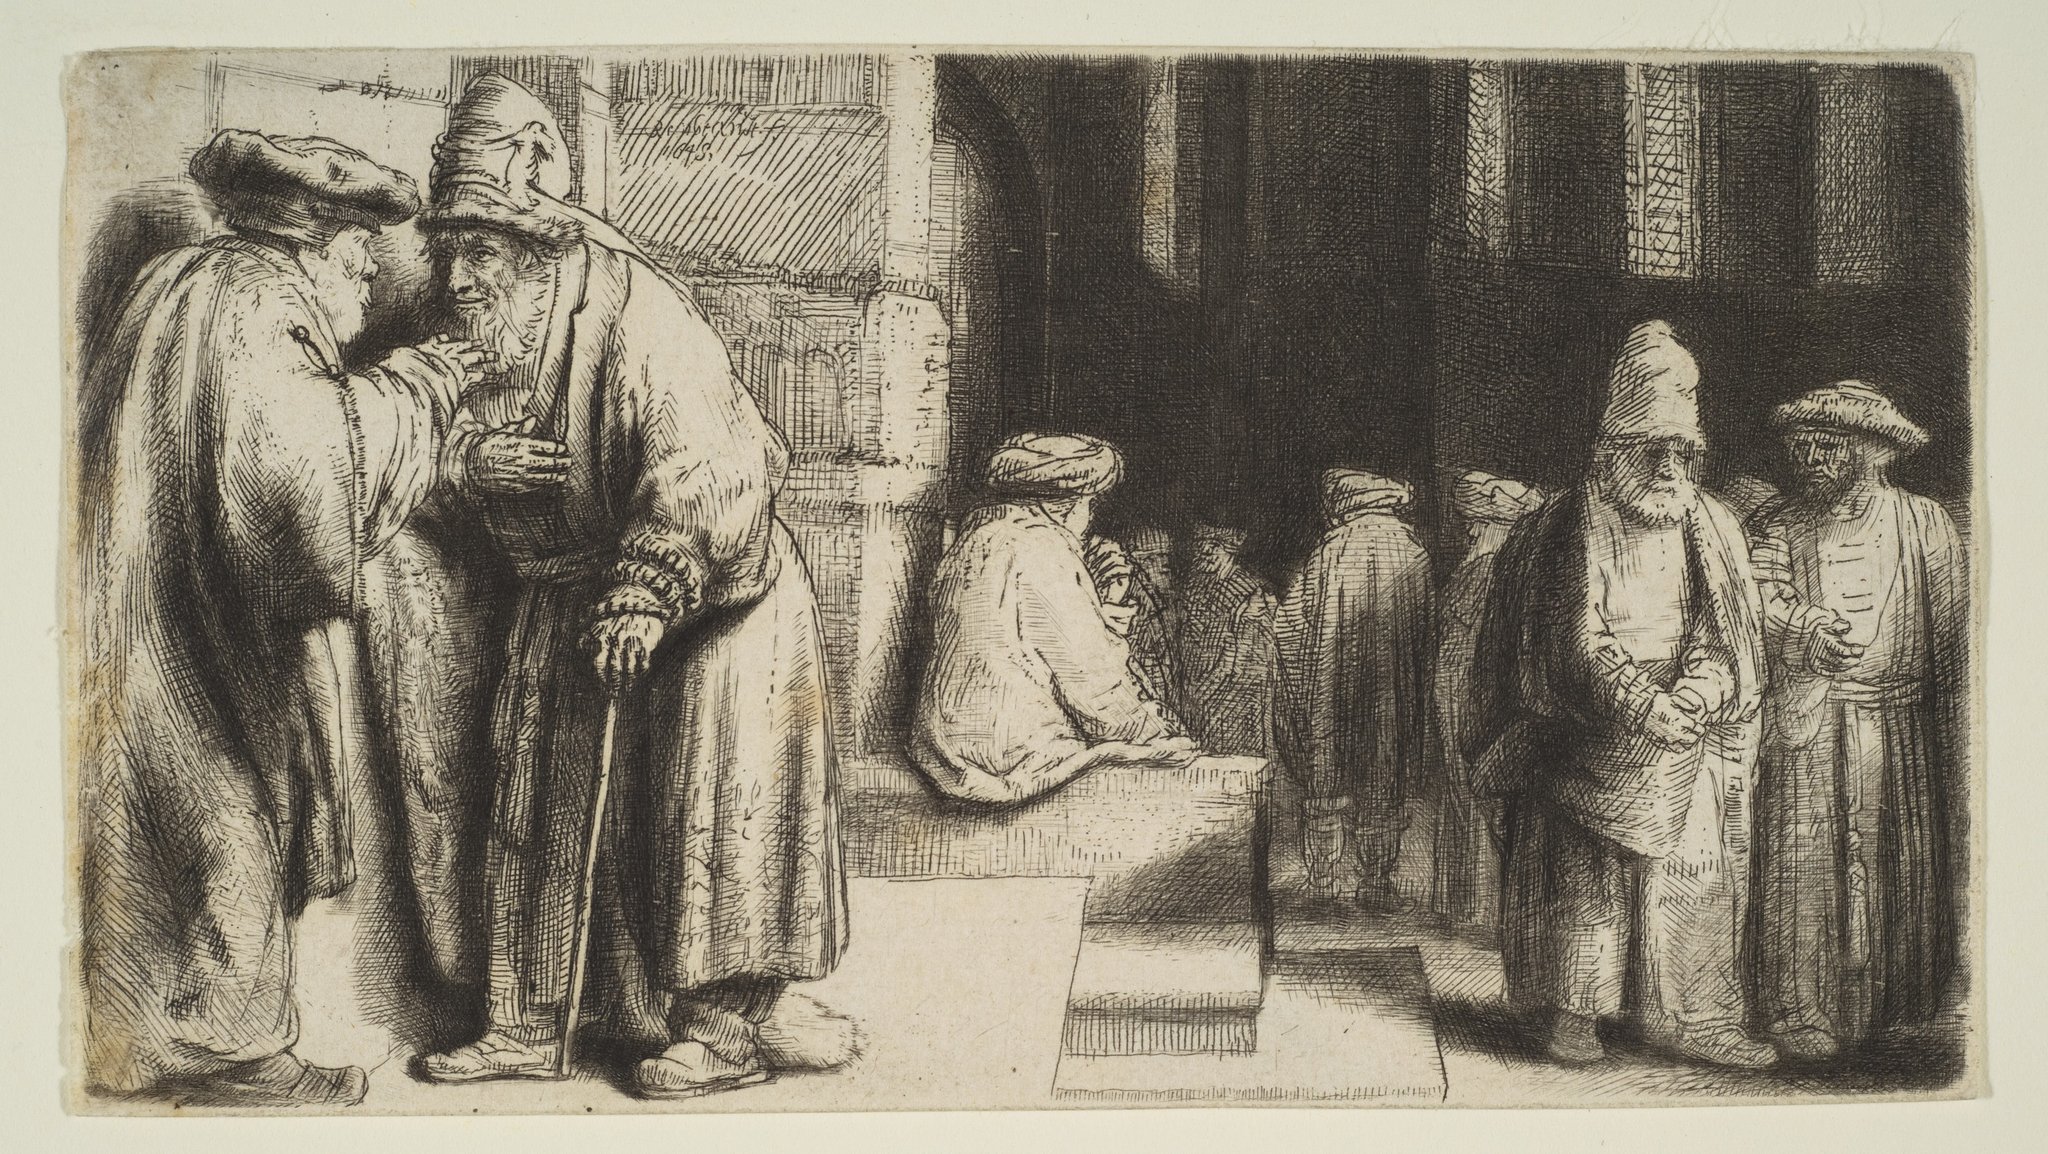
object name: print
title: Jews in a Synagogue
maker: rembrandt van rijn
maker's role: artist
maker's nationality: dutch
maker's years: 1606-1669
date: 1648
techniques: drypoint, etching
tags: men